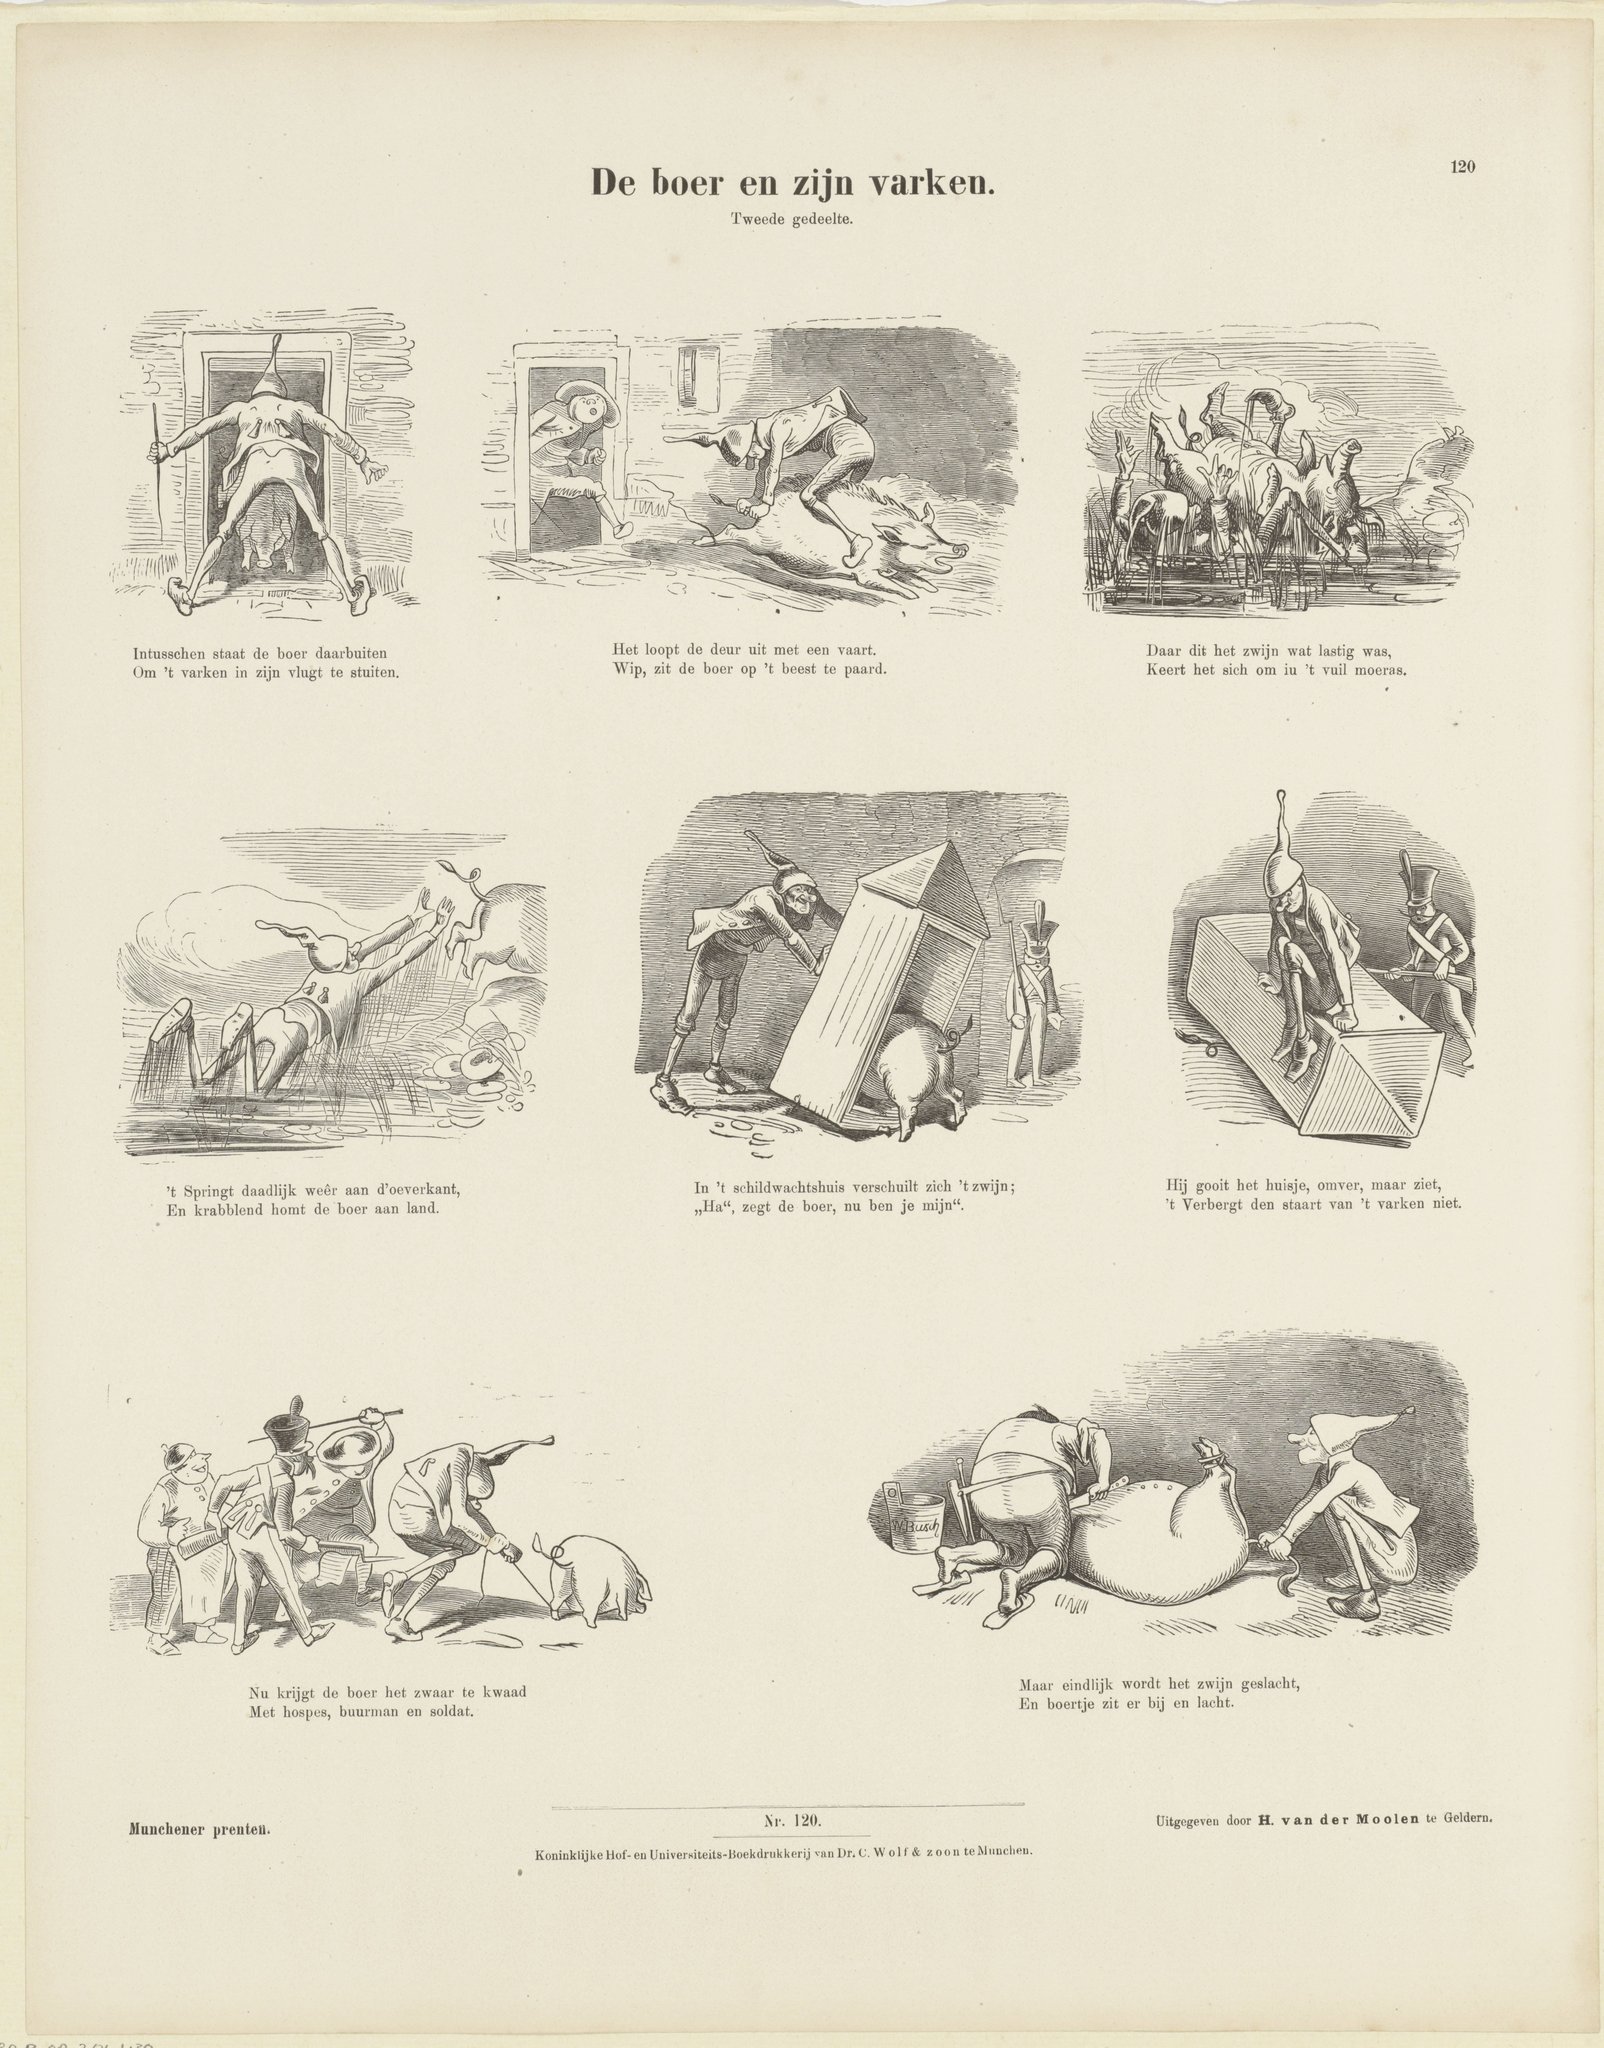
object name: print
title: Munchener platen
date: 1843-1920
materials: paper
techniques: letterpress printing, engraving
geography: munich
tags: pig, farmers, slaughtered ox or pig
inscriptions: collector's mark: Lugt 2760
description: Blad met 8 voorstellingen van een boer die een varken vangt en doodt. Onder elke afbeelding een tweeregelig vers. Genummerd midden onder: Nro. 120. Genummerd rechtsboven: 120.